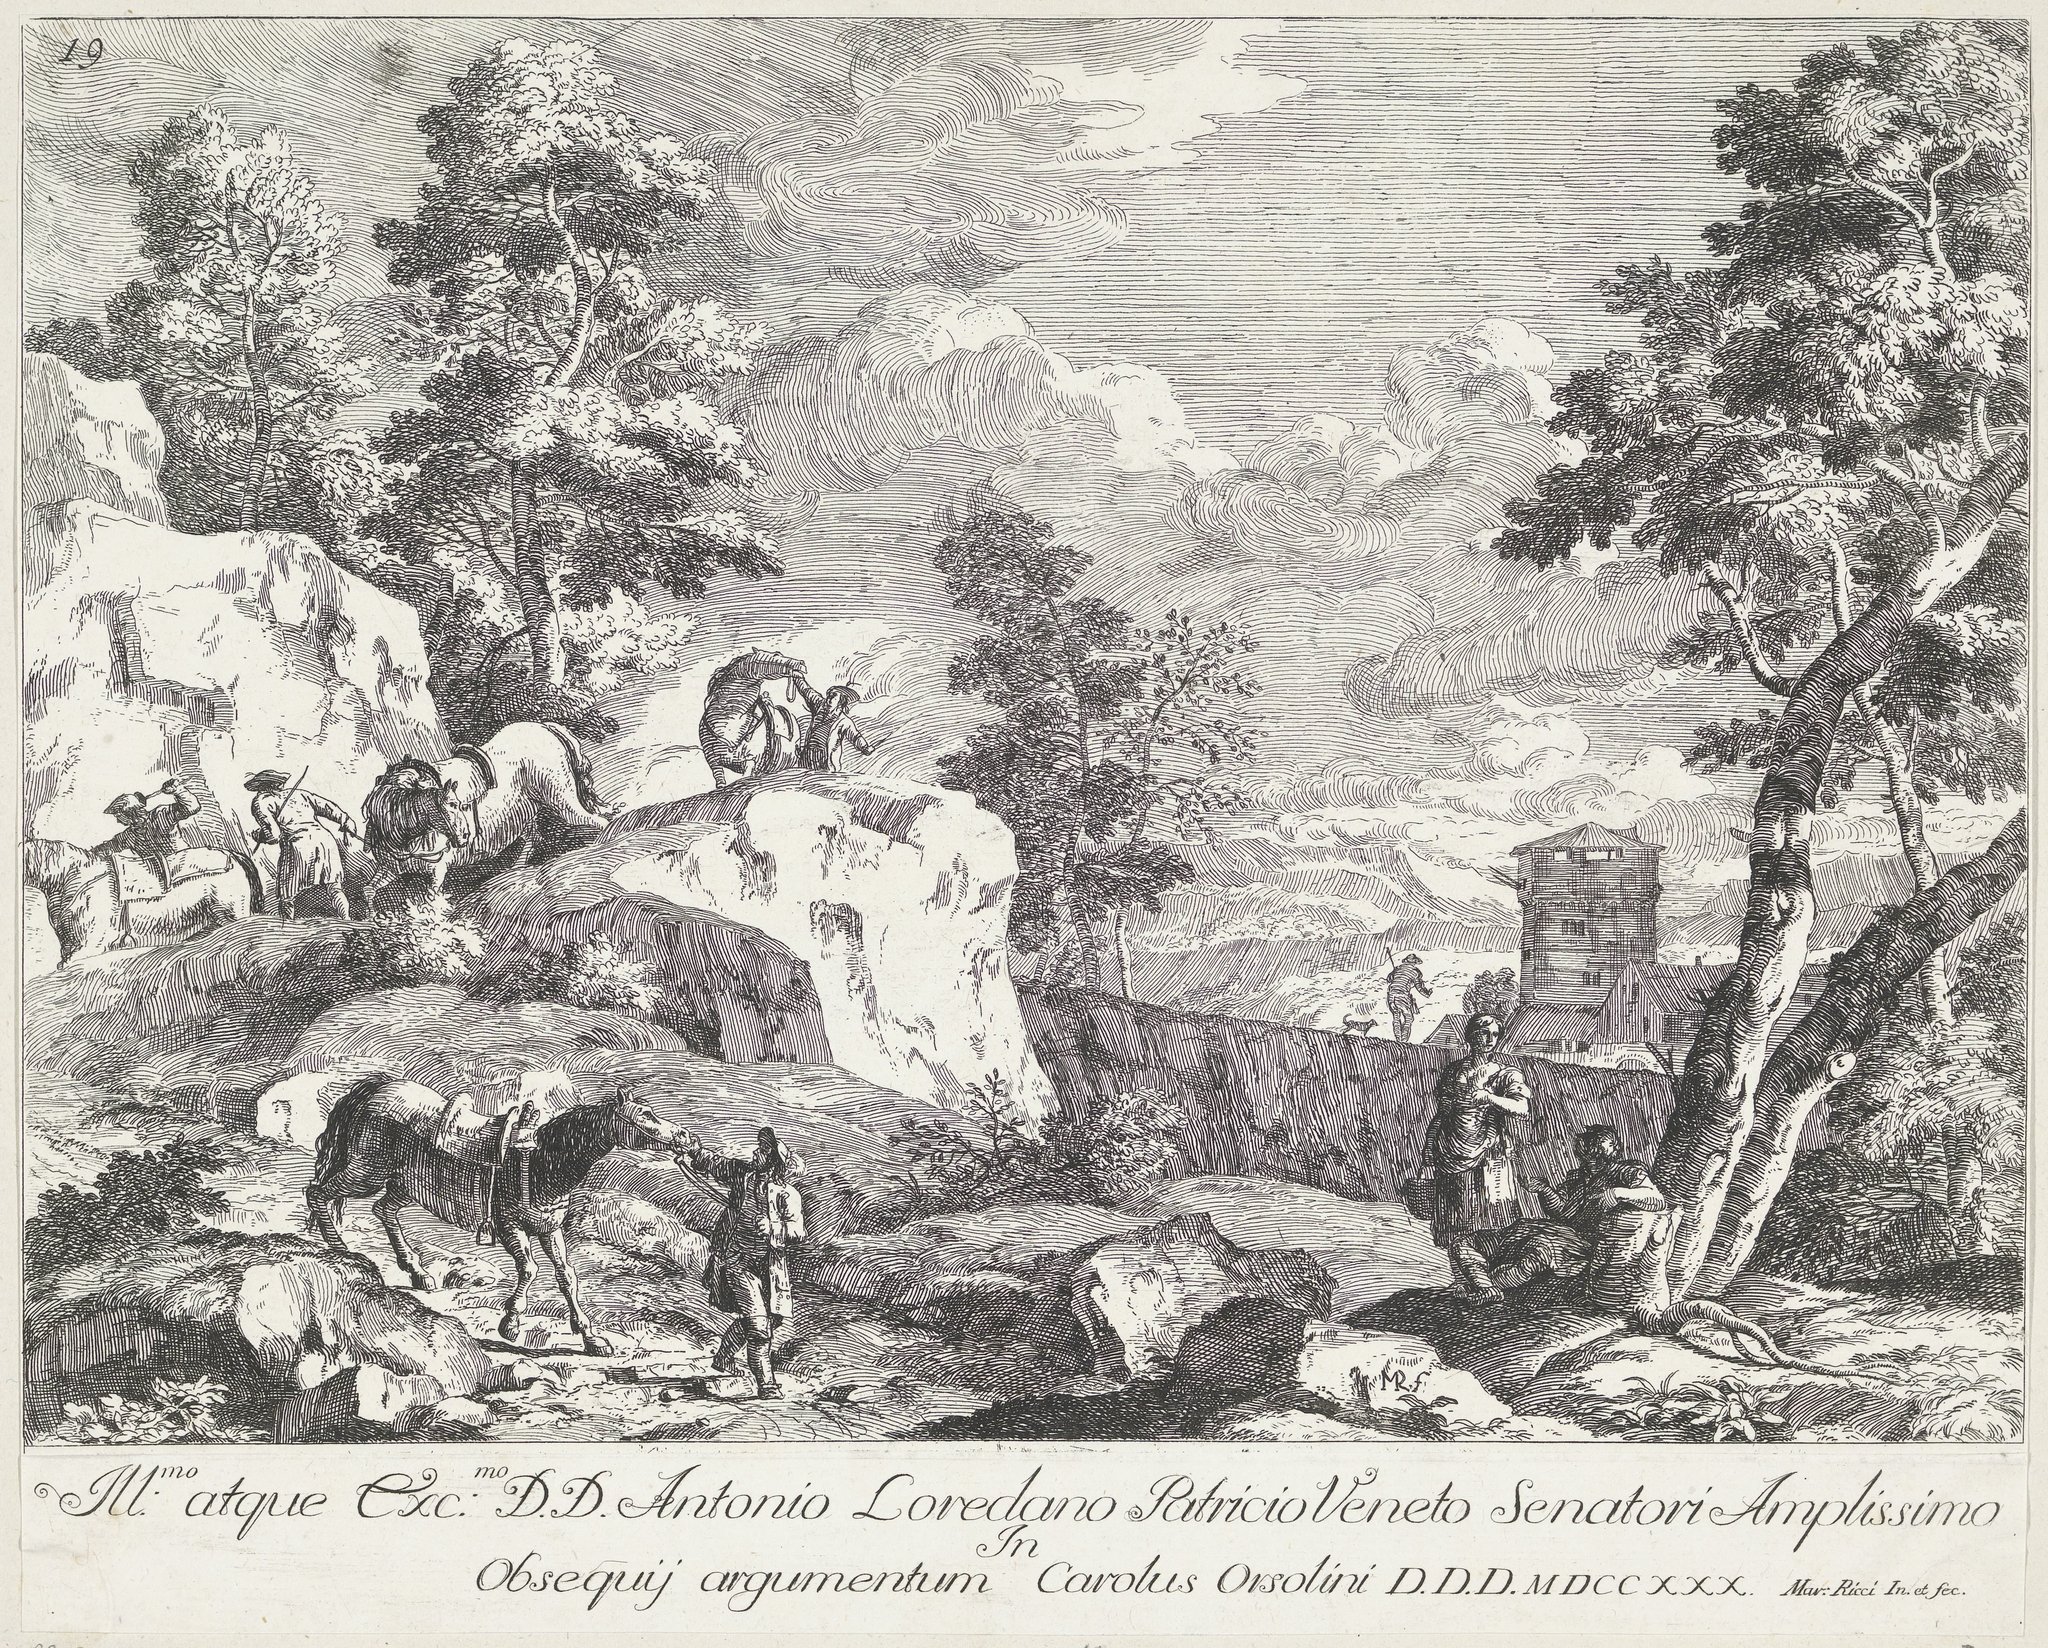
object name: print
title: Varia Marci Ricci Pictoris prestantissimi Experiment (...)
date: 1730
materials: paper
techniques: etching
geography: italy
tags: landscapes, leading a horse by the reins; rider beside his horse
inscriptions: collector's mark: Lugt 2228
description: Deze prent maakt deel uit van een reeks van twintig prenten door Marco Ricci. De prenten zijn na de dood van Ricci in 1730 gebundeld door Carlo Orsolini en voorzien van een titelprent. Getekende voorstudies worden bewaard in de Pierpont Morgan Library te New York en in Windsor Castle te Windsor.